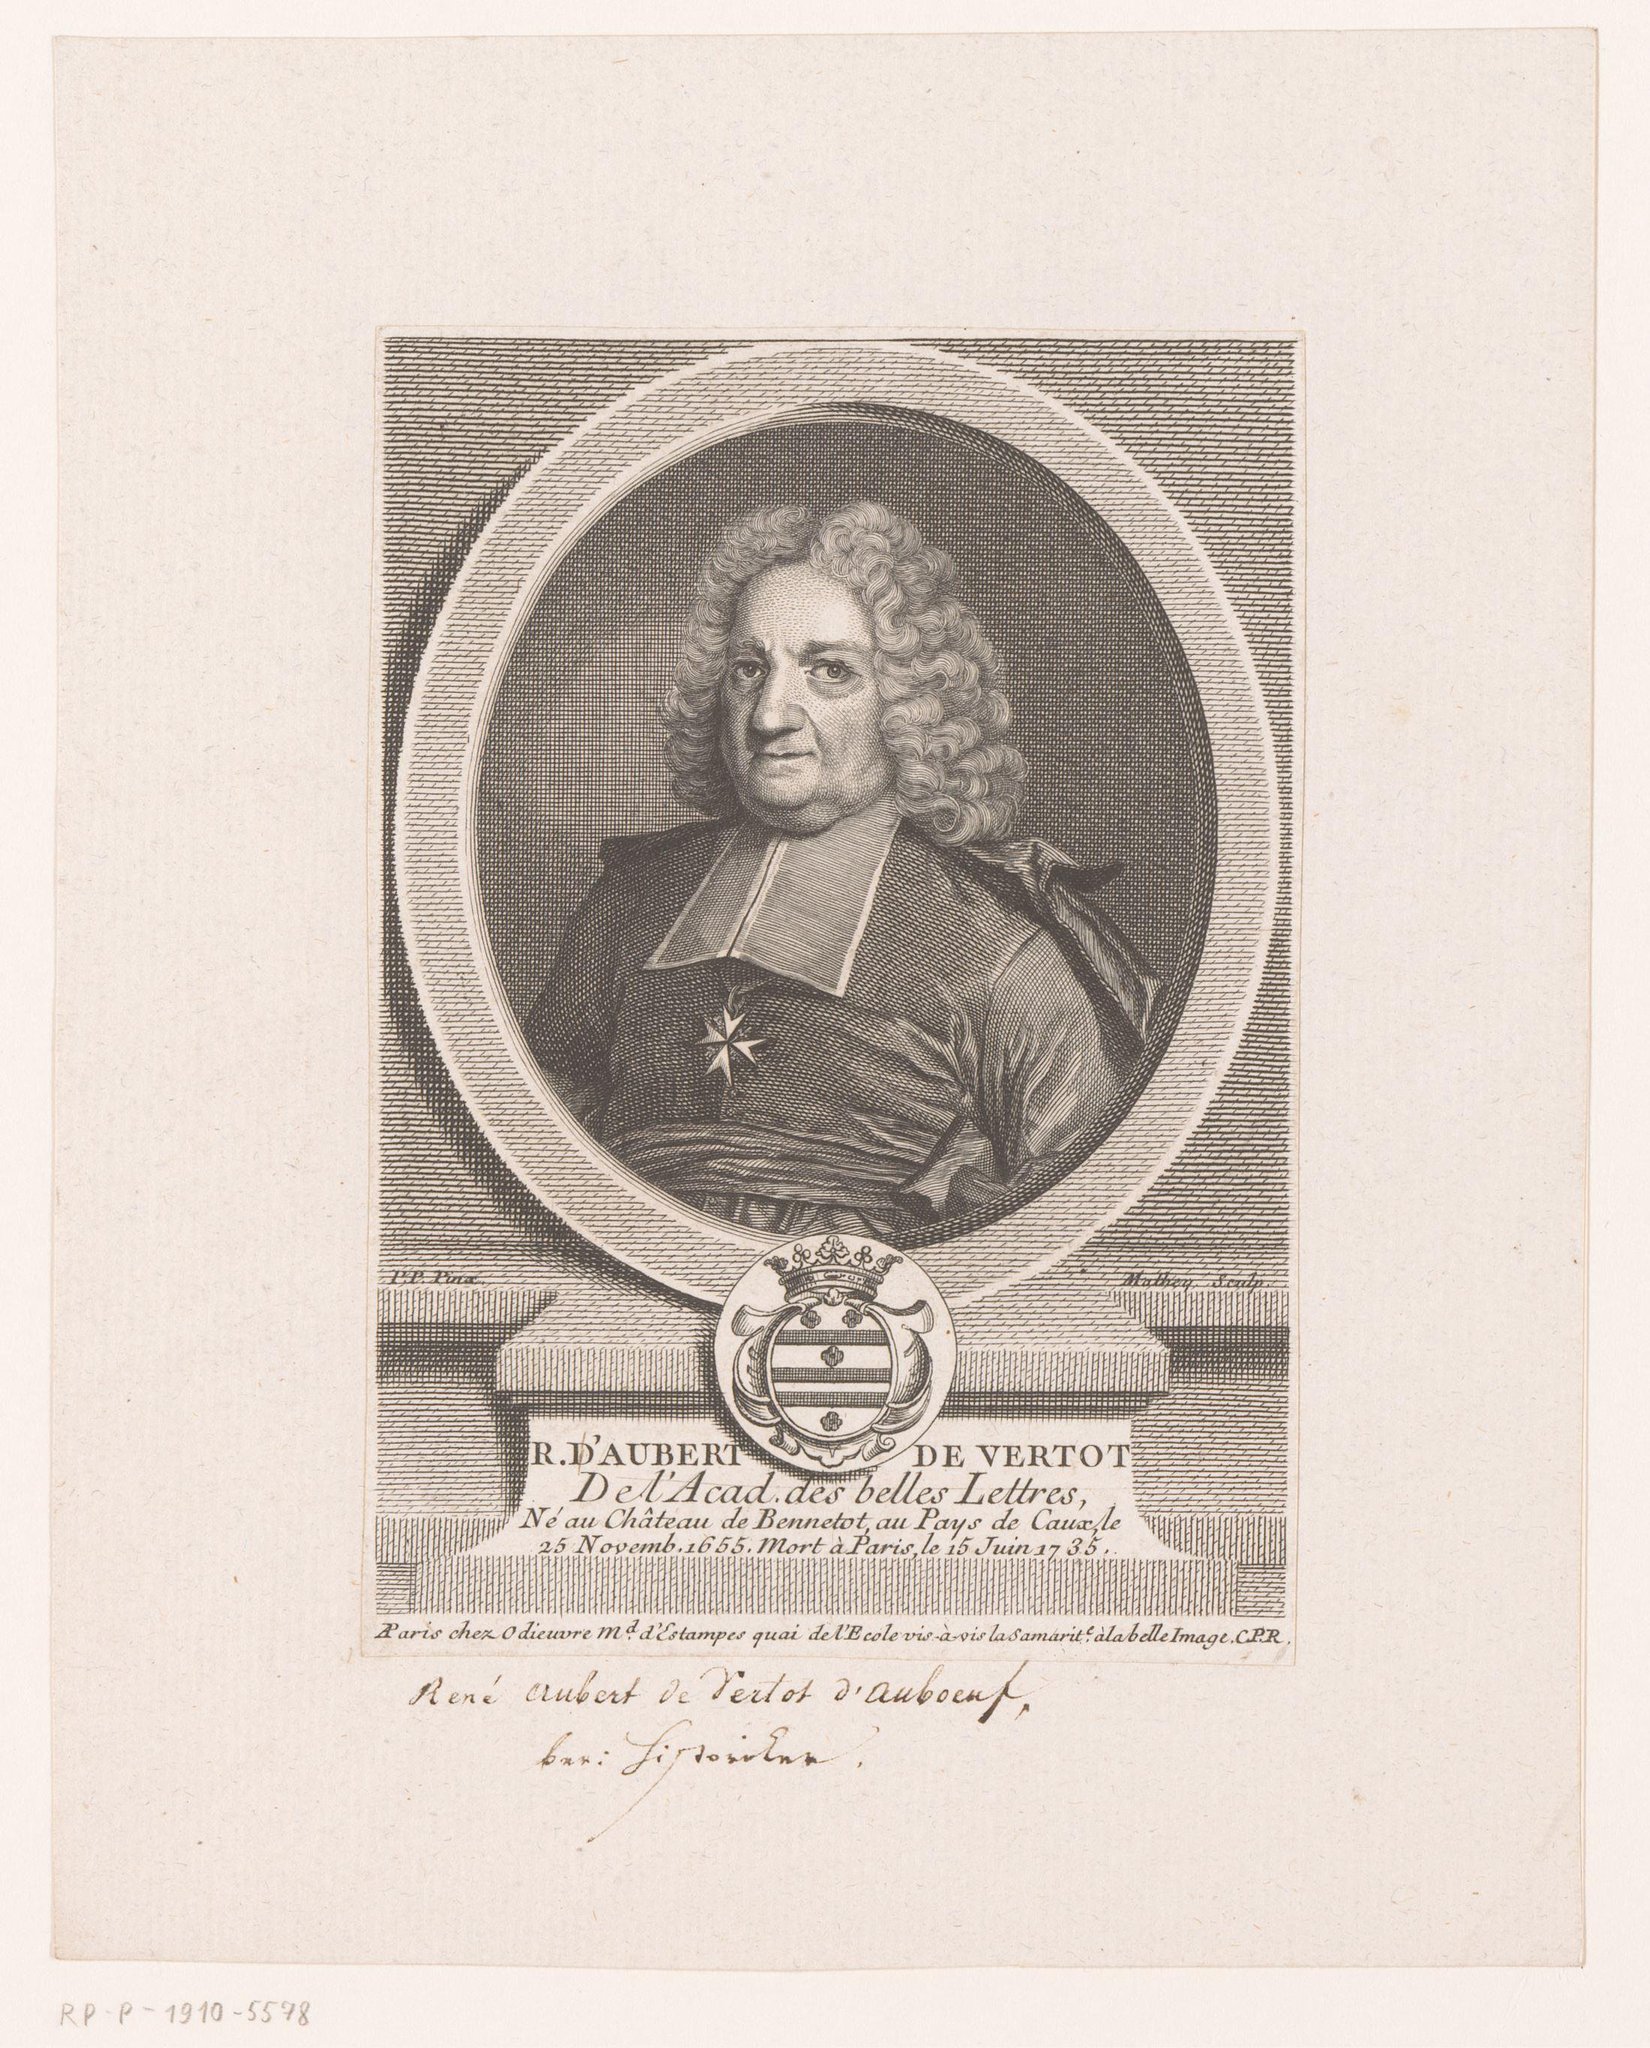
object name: book illustration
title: Portret van René-Aubert Vertot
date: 1755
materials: paper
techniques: engraving, etching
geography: france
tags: paris, priest, historical persons, armorial bearing, heraldry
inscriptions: inscription, collector's mark: Lugt 2228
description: Prent uit: Dreux du Radier, Jean-François. L'Europe illustré, contenant l'histoire abregée des souverains, des princes, des prélats, des ministres, (...) en Europe: dans le XVe. siècle compris, jusqu'à présent. Parijs: Michel Odieuvre en Jean-Luc Nyon, ca. 1755.